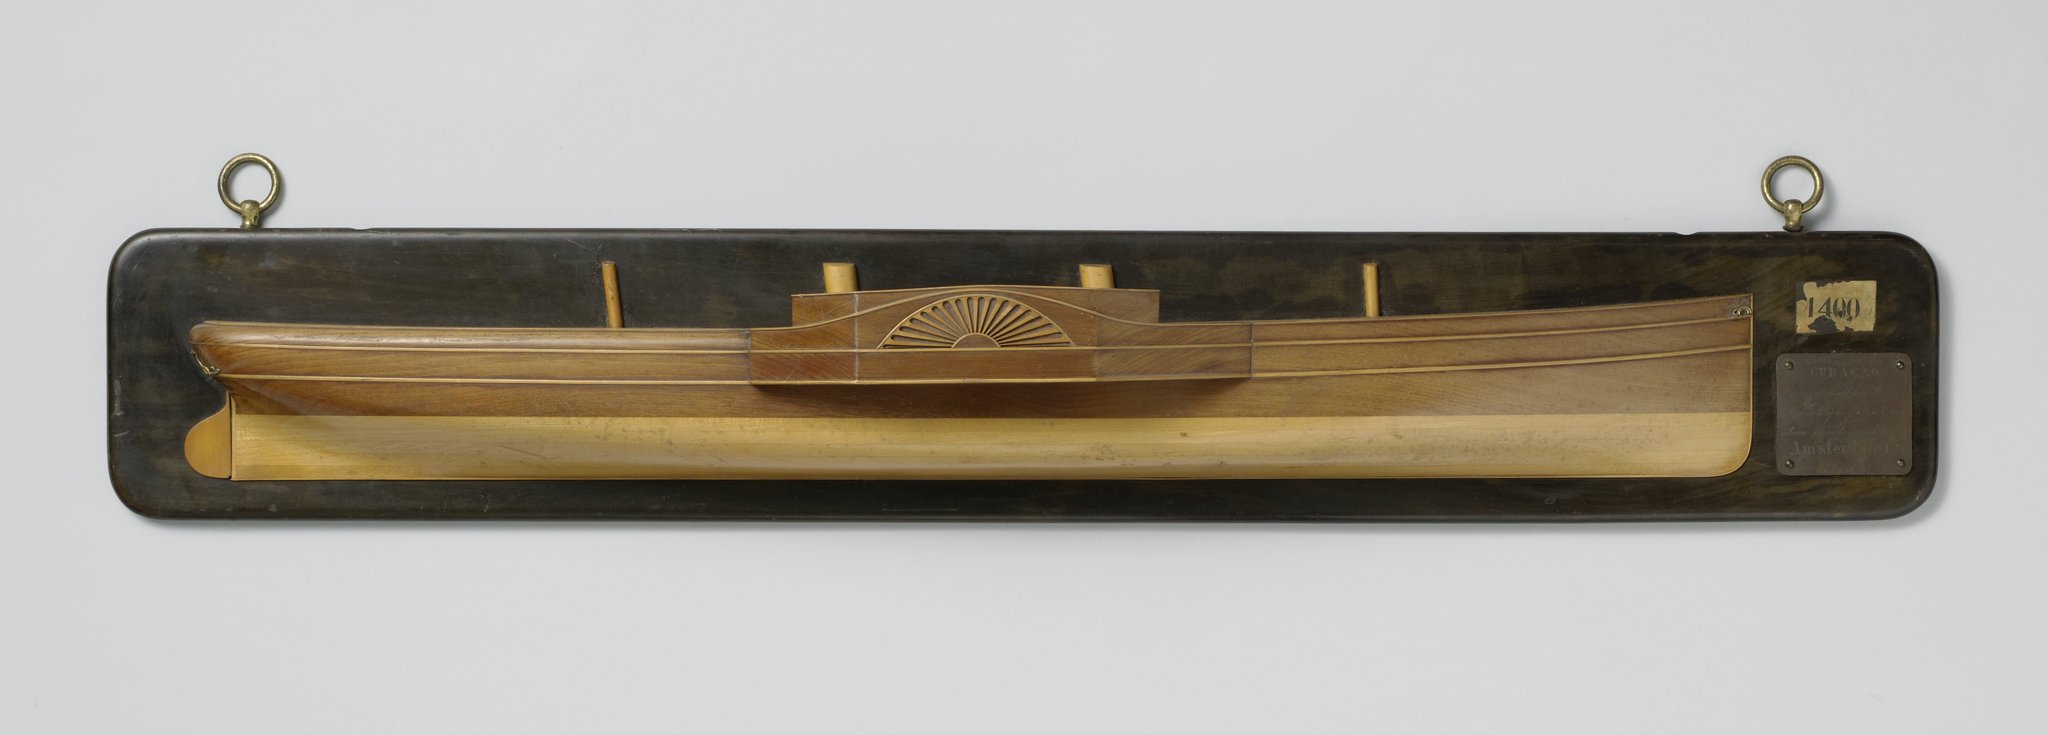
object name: builder's model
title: Half Model of a Paddle Steamer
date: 1878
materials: brass, wood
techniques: polychromy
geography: amsterdam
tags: curaçao (schip)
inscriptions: inscription, bottom right, on a square metal label: ‘RADERSTOOMSCHIP / CURACAO / gebouwd aan de / koninklijke fabriek van / stoom en andere werktuigen / Amsterdam 1878 / Schaal 1/50’, label, top right: ‘1400’ former inventory label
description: Het raderstoomschip Curaçao, gebouwd bij de Koninklijke Fabriek voor Stoom- en andere Werktuigen in Amsterdam in 1878, was geen Marine-vaartuig. We hebben geen informatie over het schip.